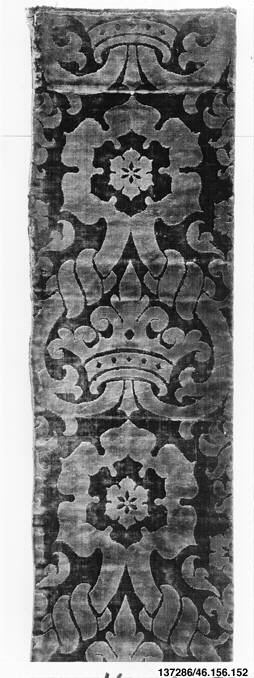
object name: piece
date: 1501-1600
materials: silk